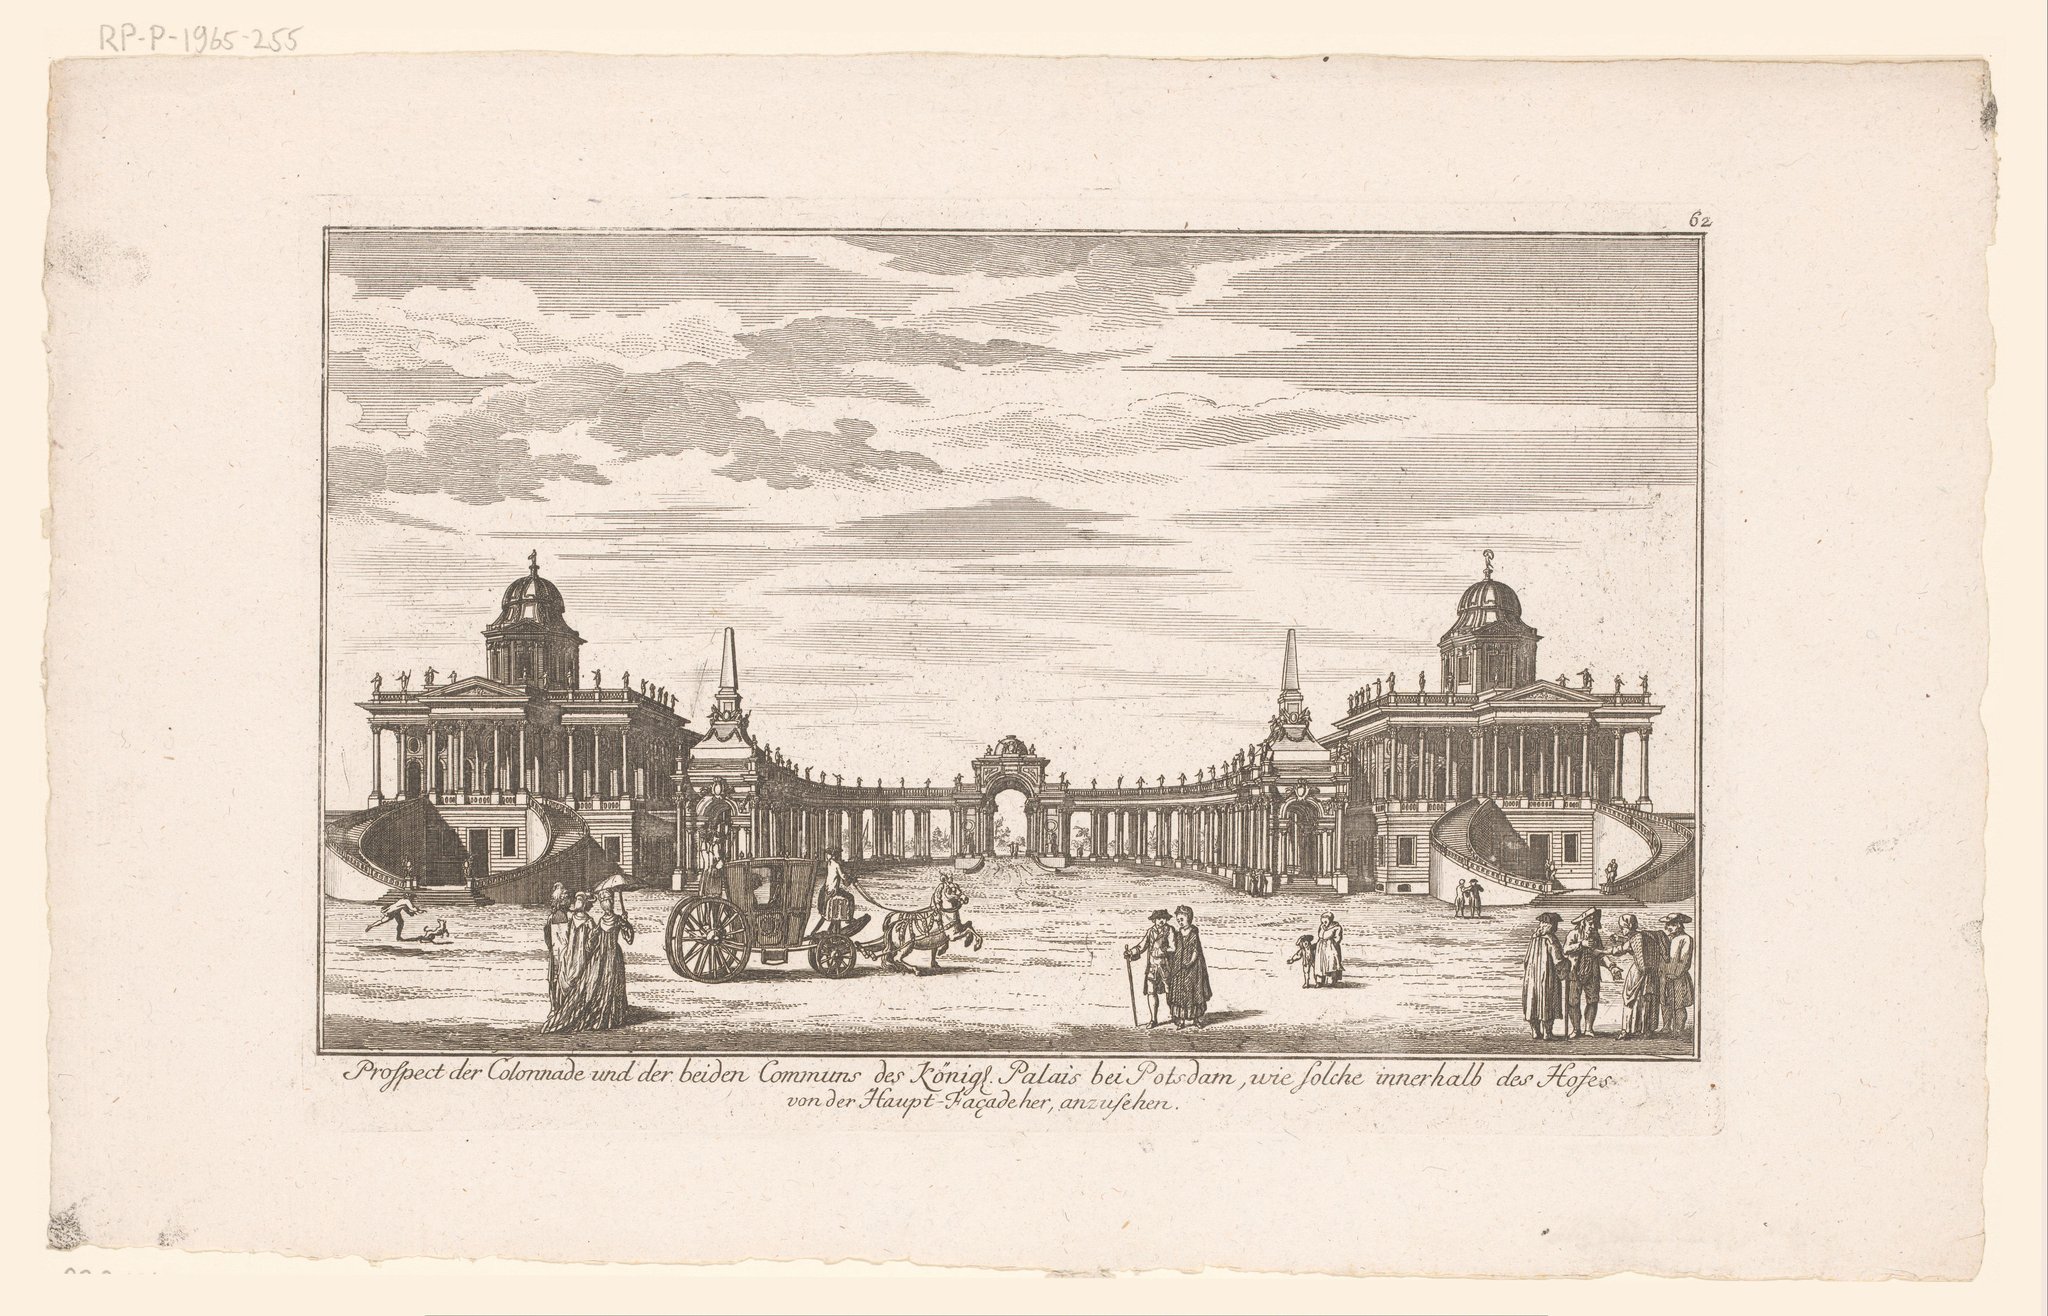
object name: print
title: Gezicht op de Communs van het Neues Palais, in het park van Slot Sanssouci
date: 1769-1774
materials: paper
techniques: engraving, etching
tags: palace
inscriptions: collector's mark: Lugt 2760, collector's mark: Lugt 2228